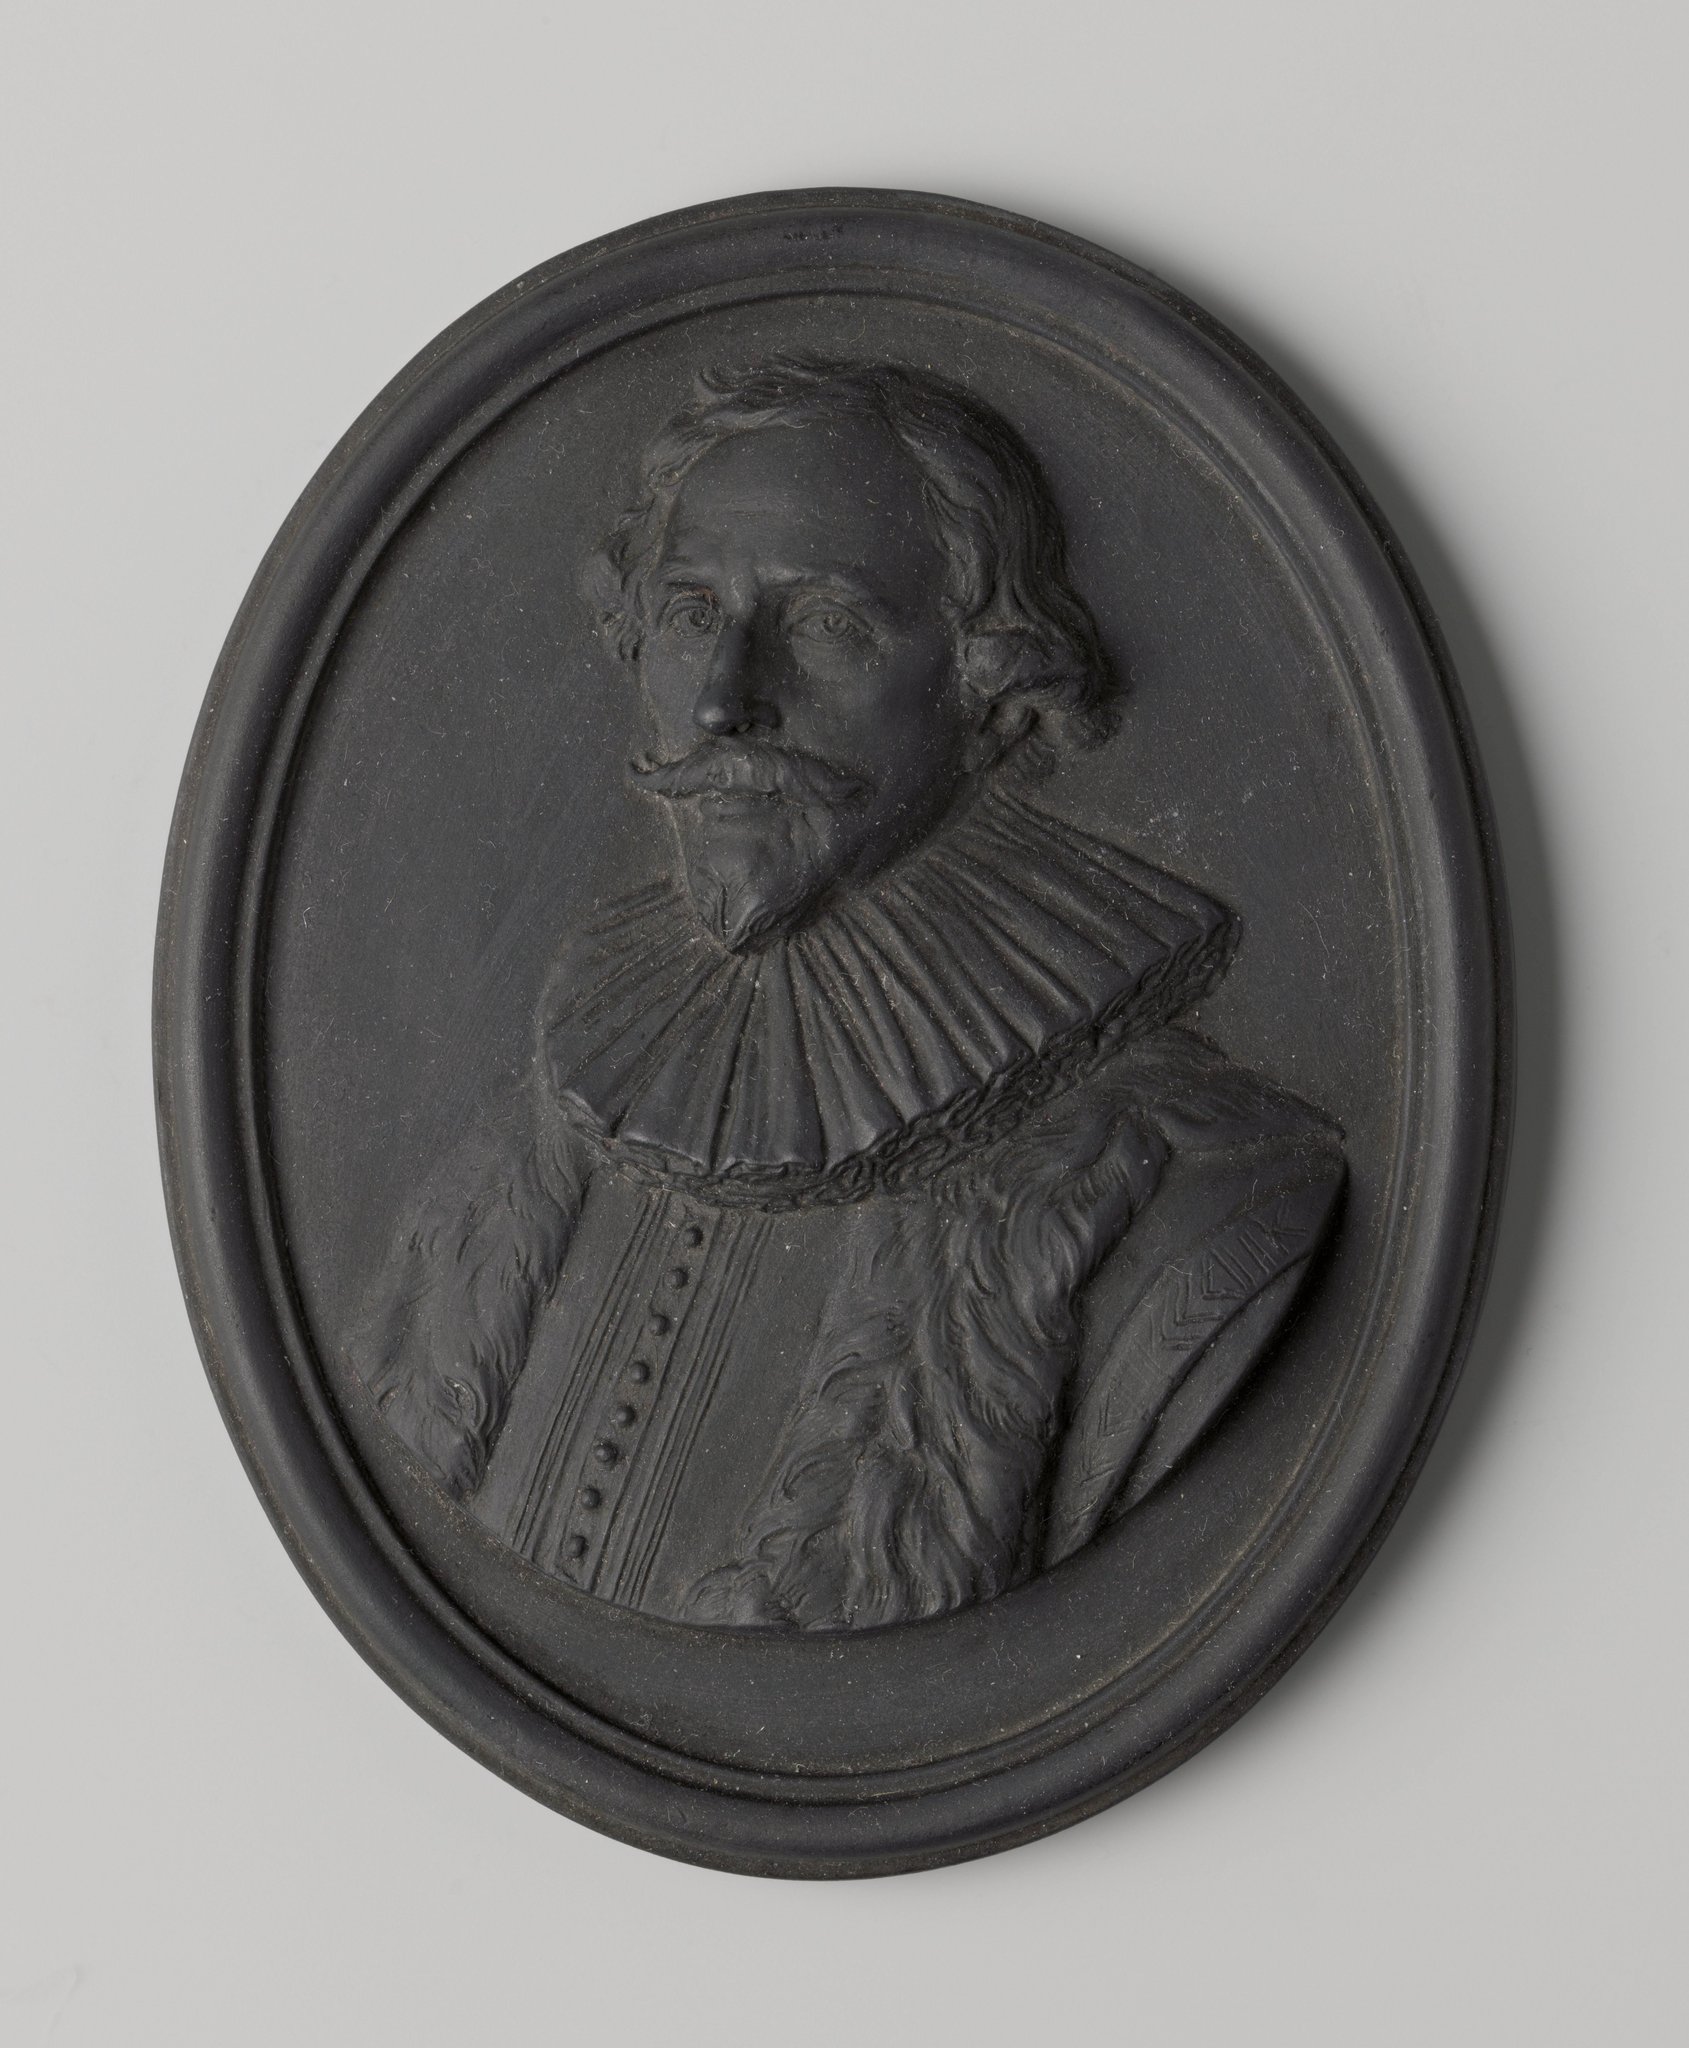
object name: plaque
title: Plaquette met portret van Jacob Cats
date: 1780-1800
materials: stoneware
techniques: firing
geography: england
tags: the hague, jacob cats (1577-1660)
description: Ovale plaquette van zwart steengoed (black basalt) met in reliëf het portret van Jacob Cats. De plaquette is op de achterzijde gemerkt: Wedgwood en Jacob Cats.